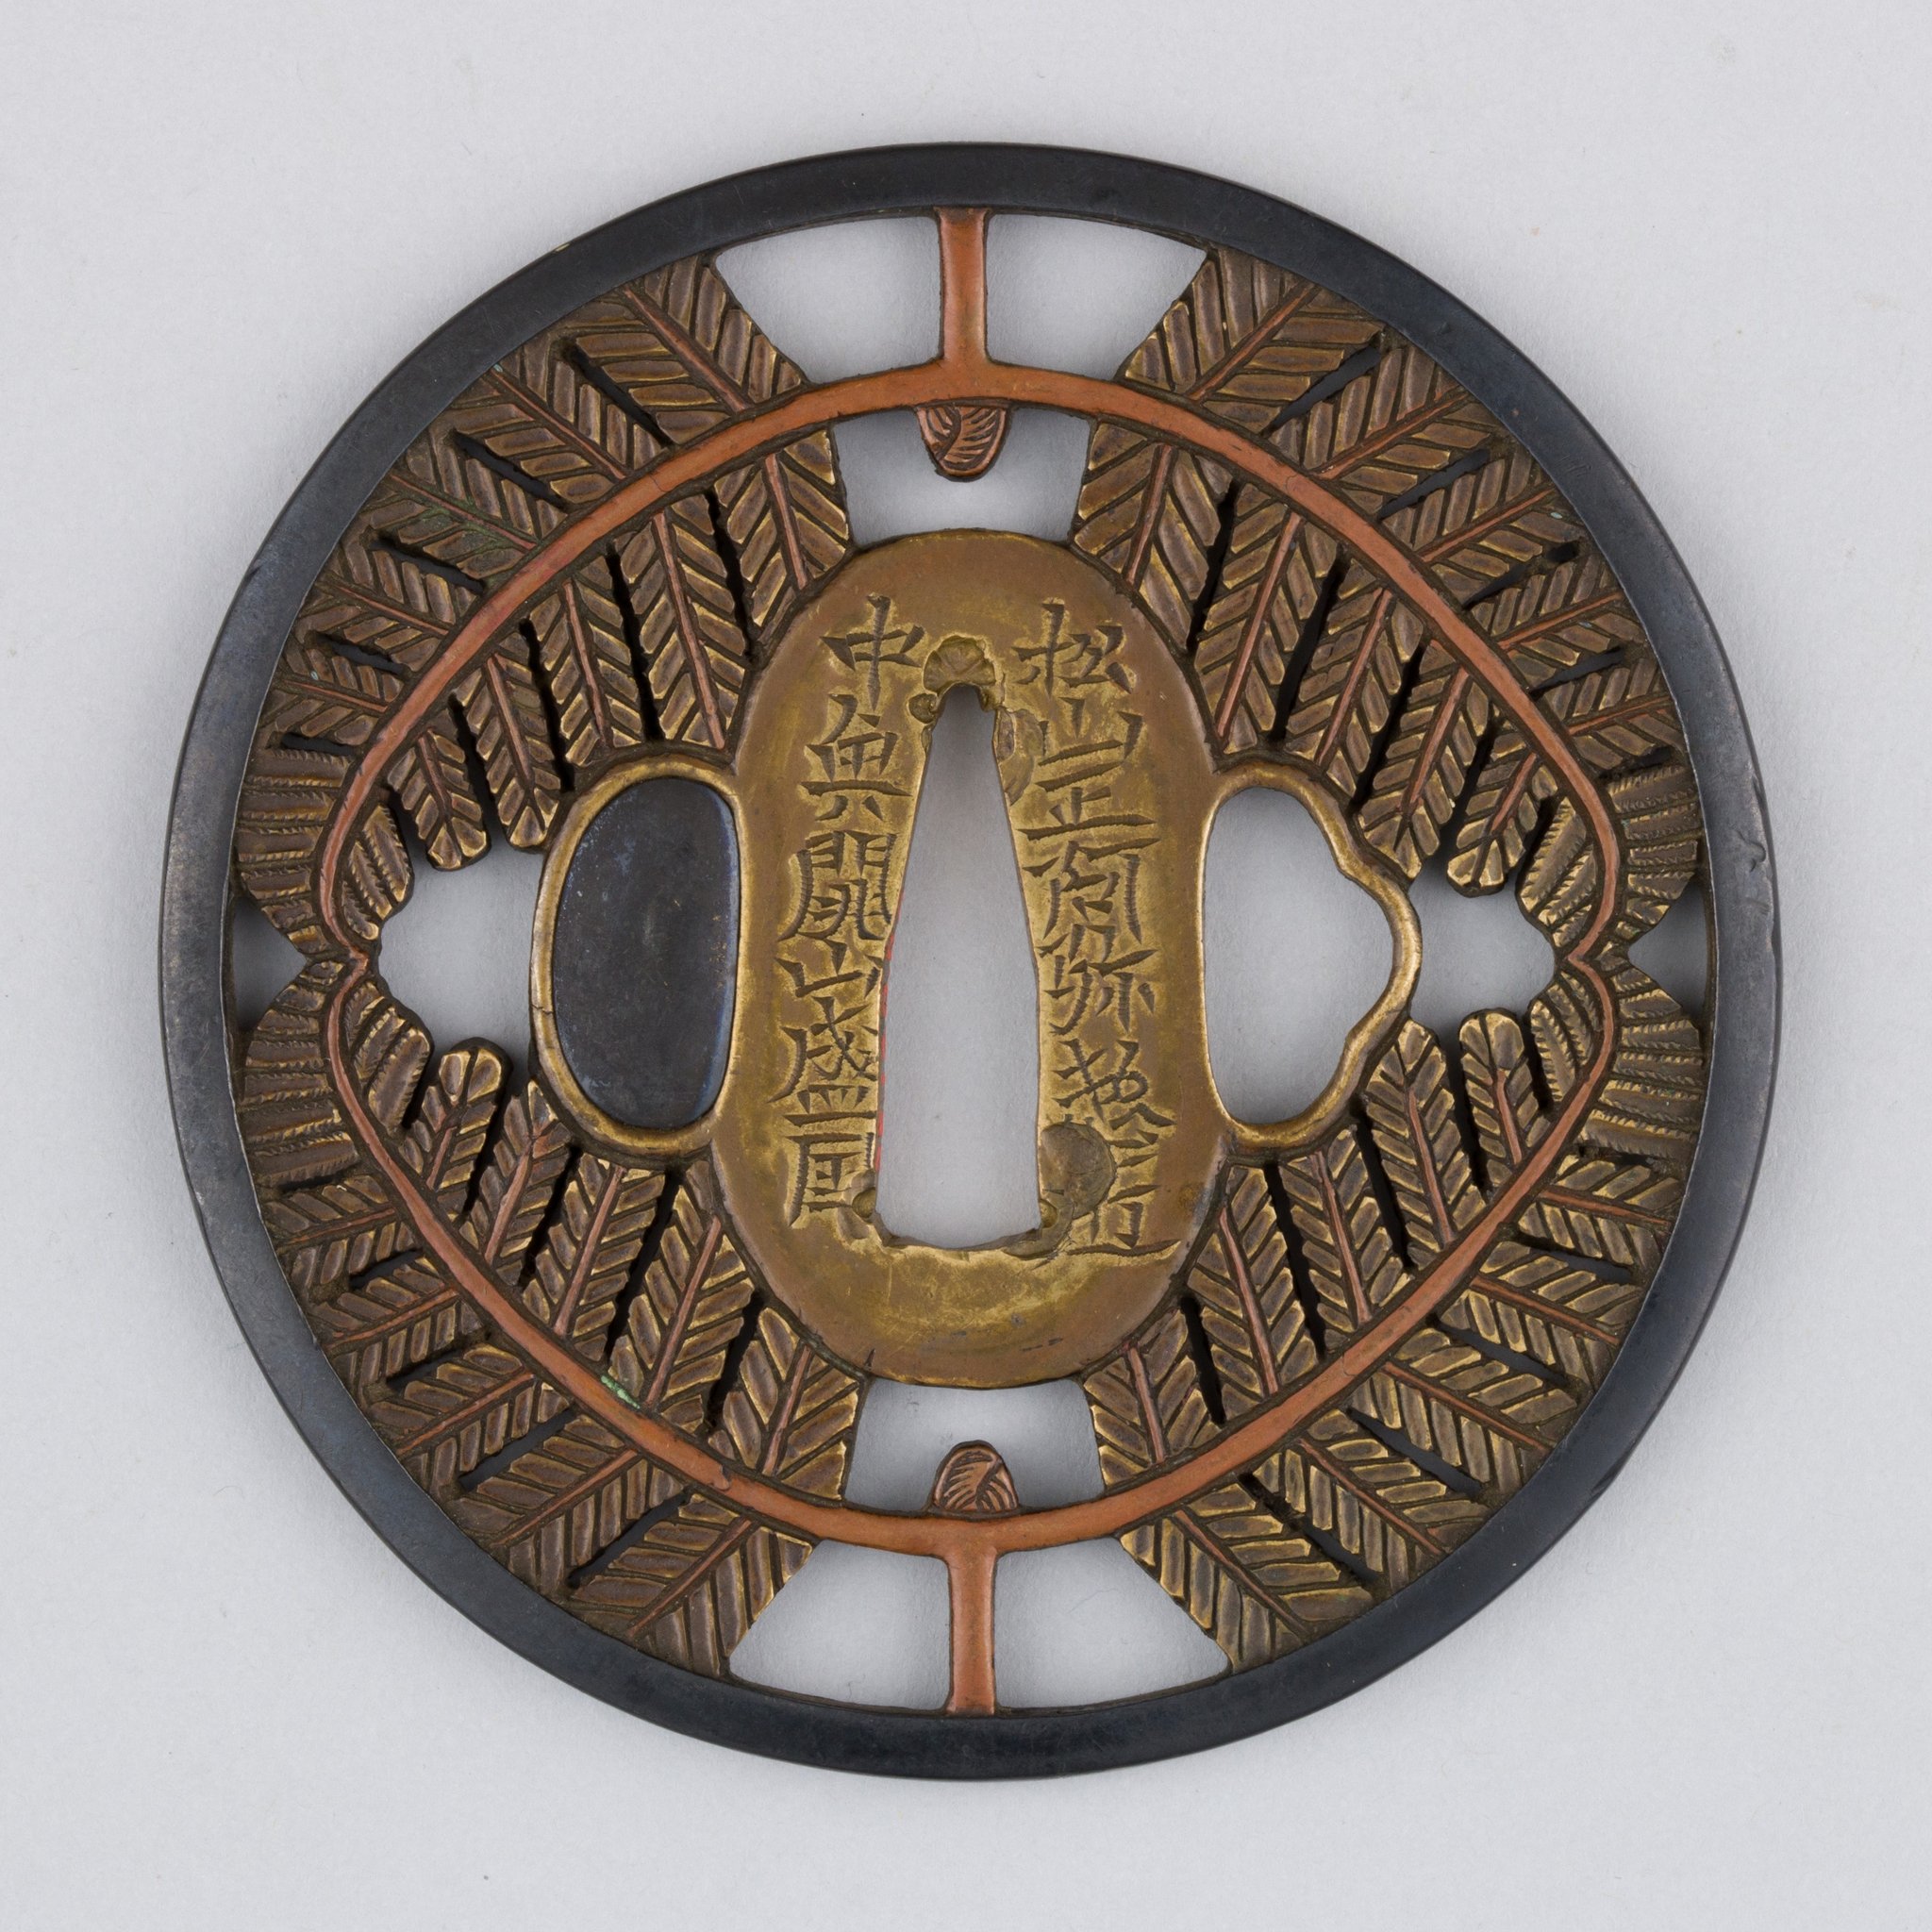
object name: sword guard tsuba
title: Sword Guard (Tsuba)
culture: japanese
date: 1701-1800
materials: copper, copper alloy, gold alloy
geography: japan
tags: leaves